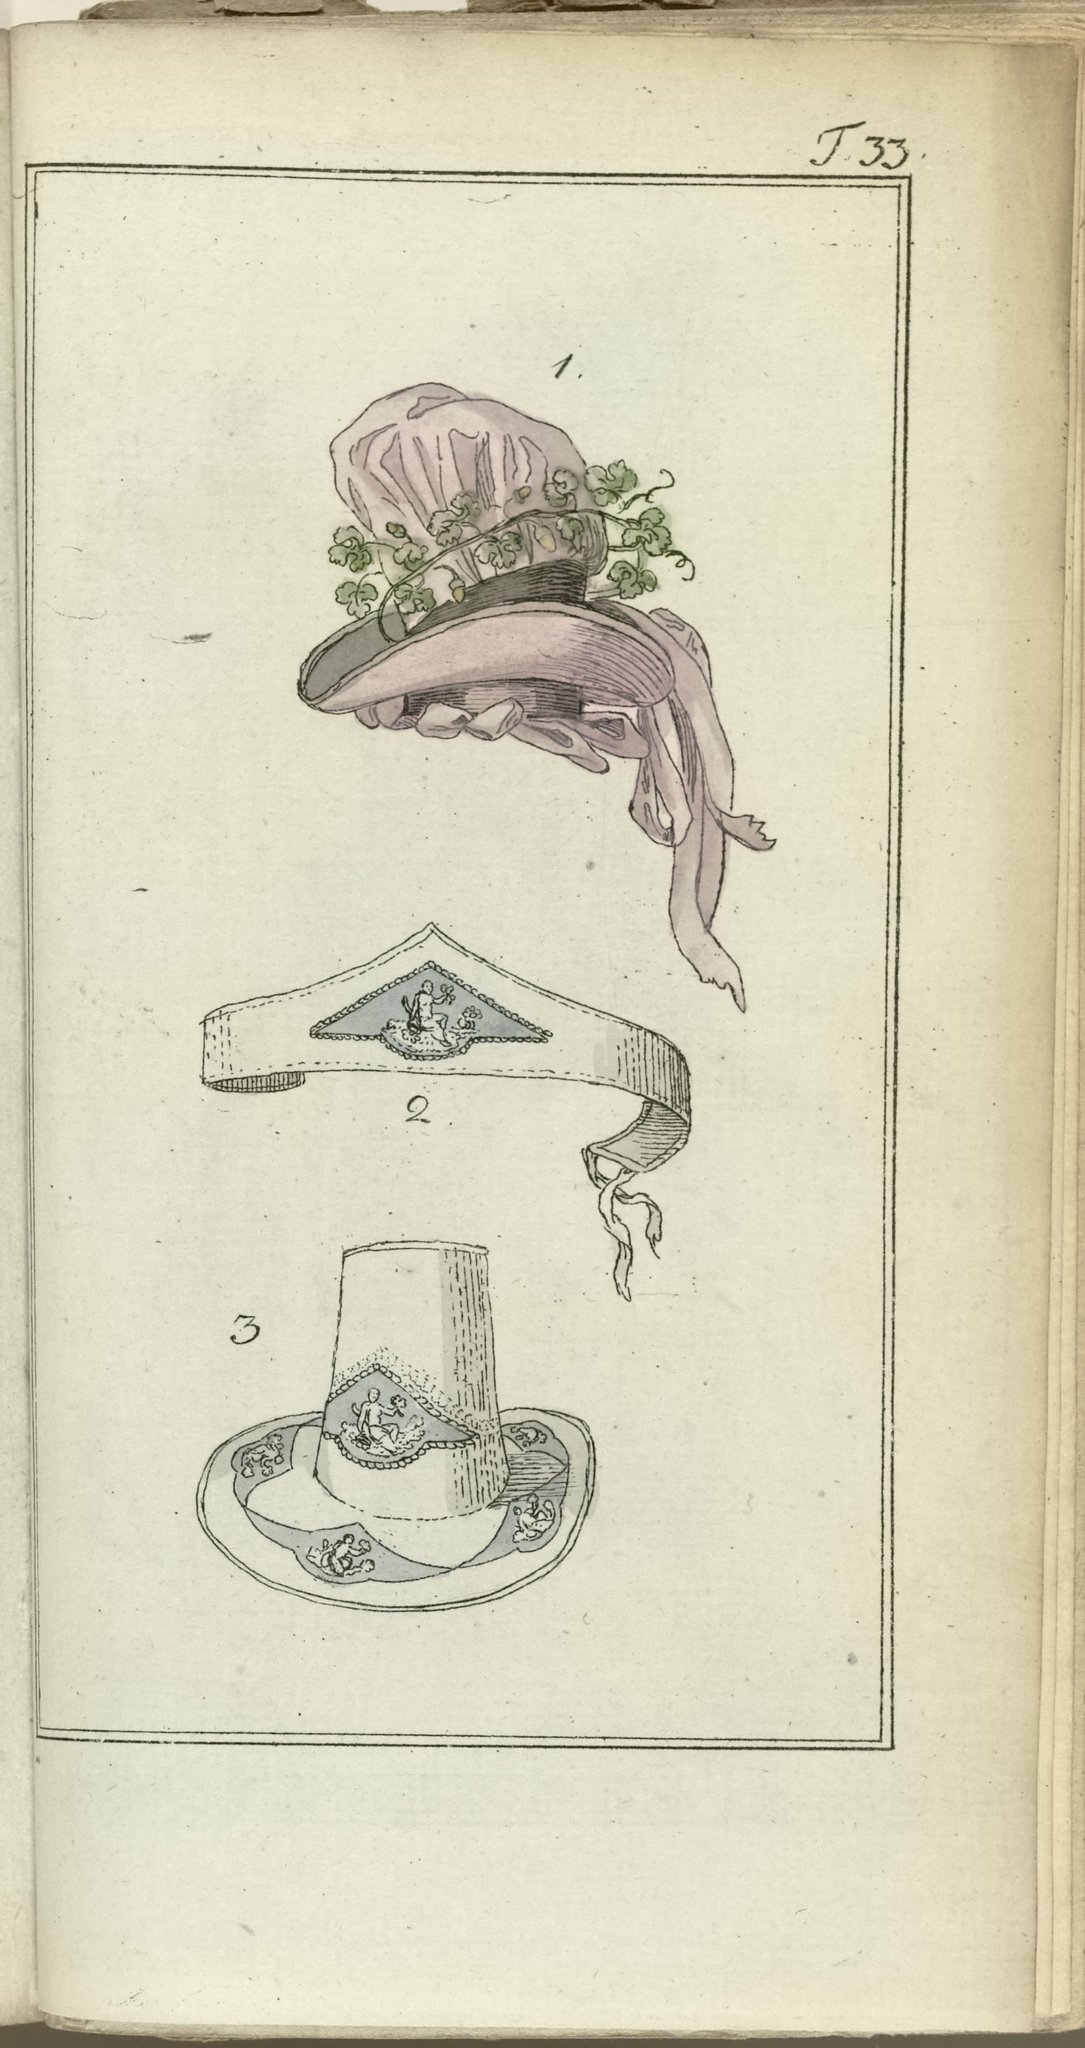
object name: magazine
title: Journal des Luxus und der Moden 1790, Band V, T.33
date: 1790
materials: paper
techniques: etching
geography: weimar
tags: fashion plates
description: Prent uit het modetijdschrift Journal des Luxus und der Moden, uitgegeven door Friedrich Justin Bertuch en Georg Melchior Kraus, Weimar, 1786-1826.